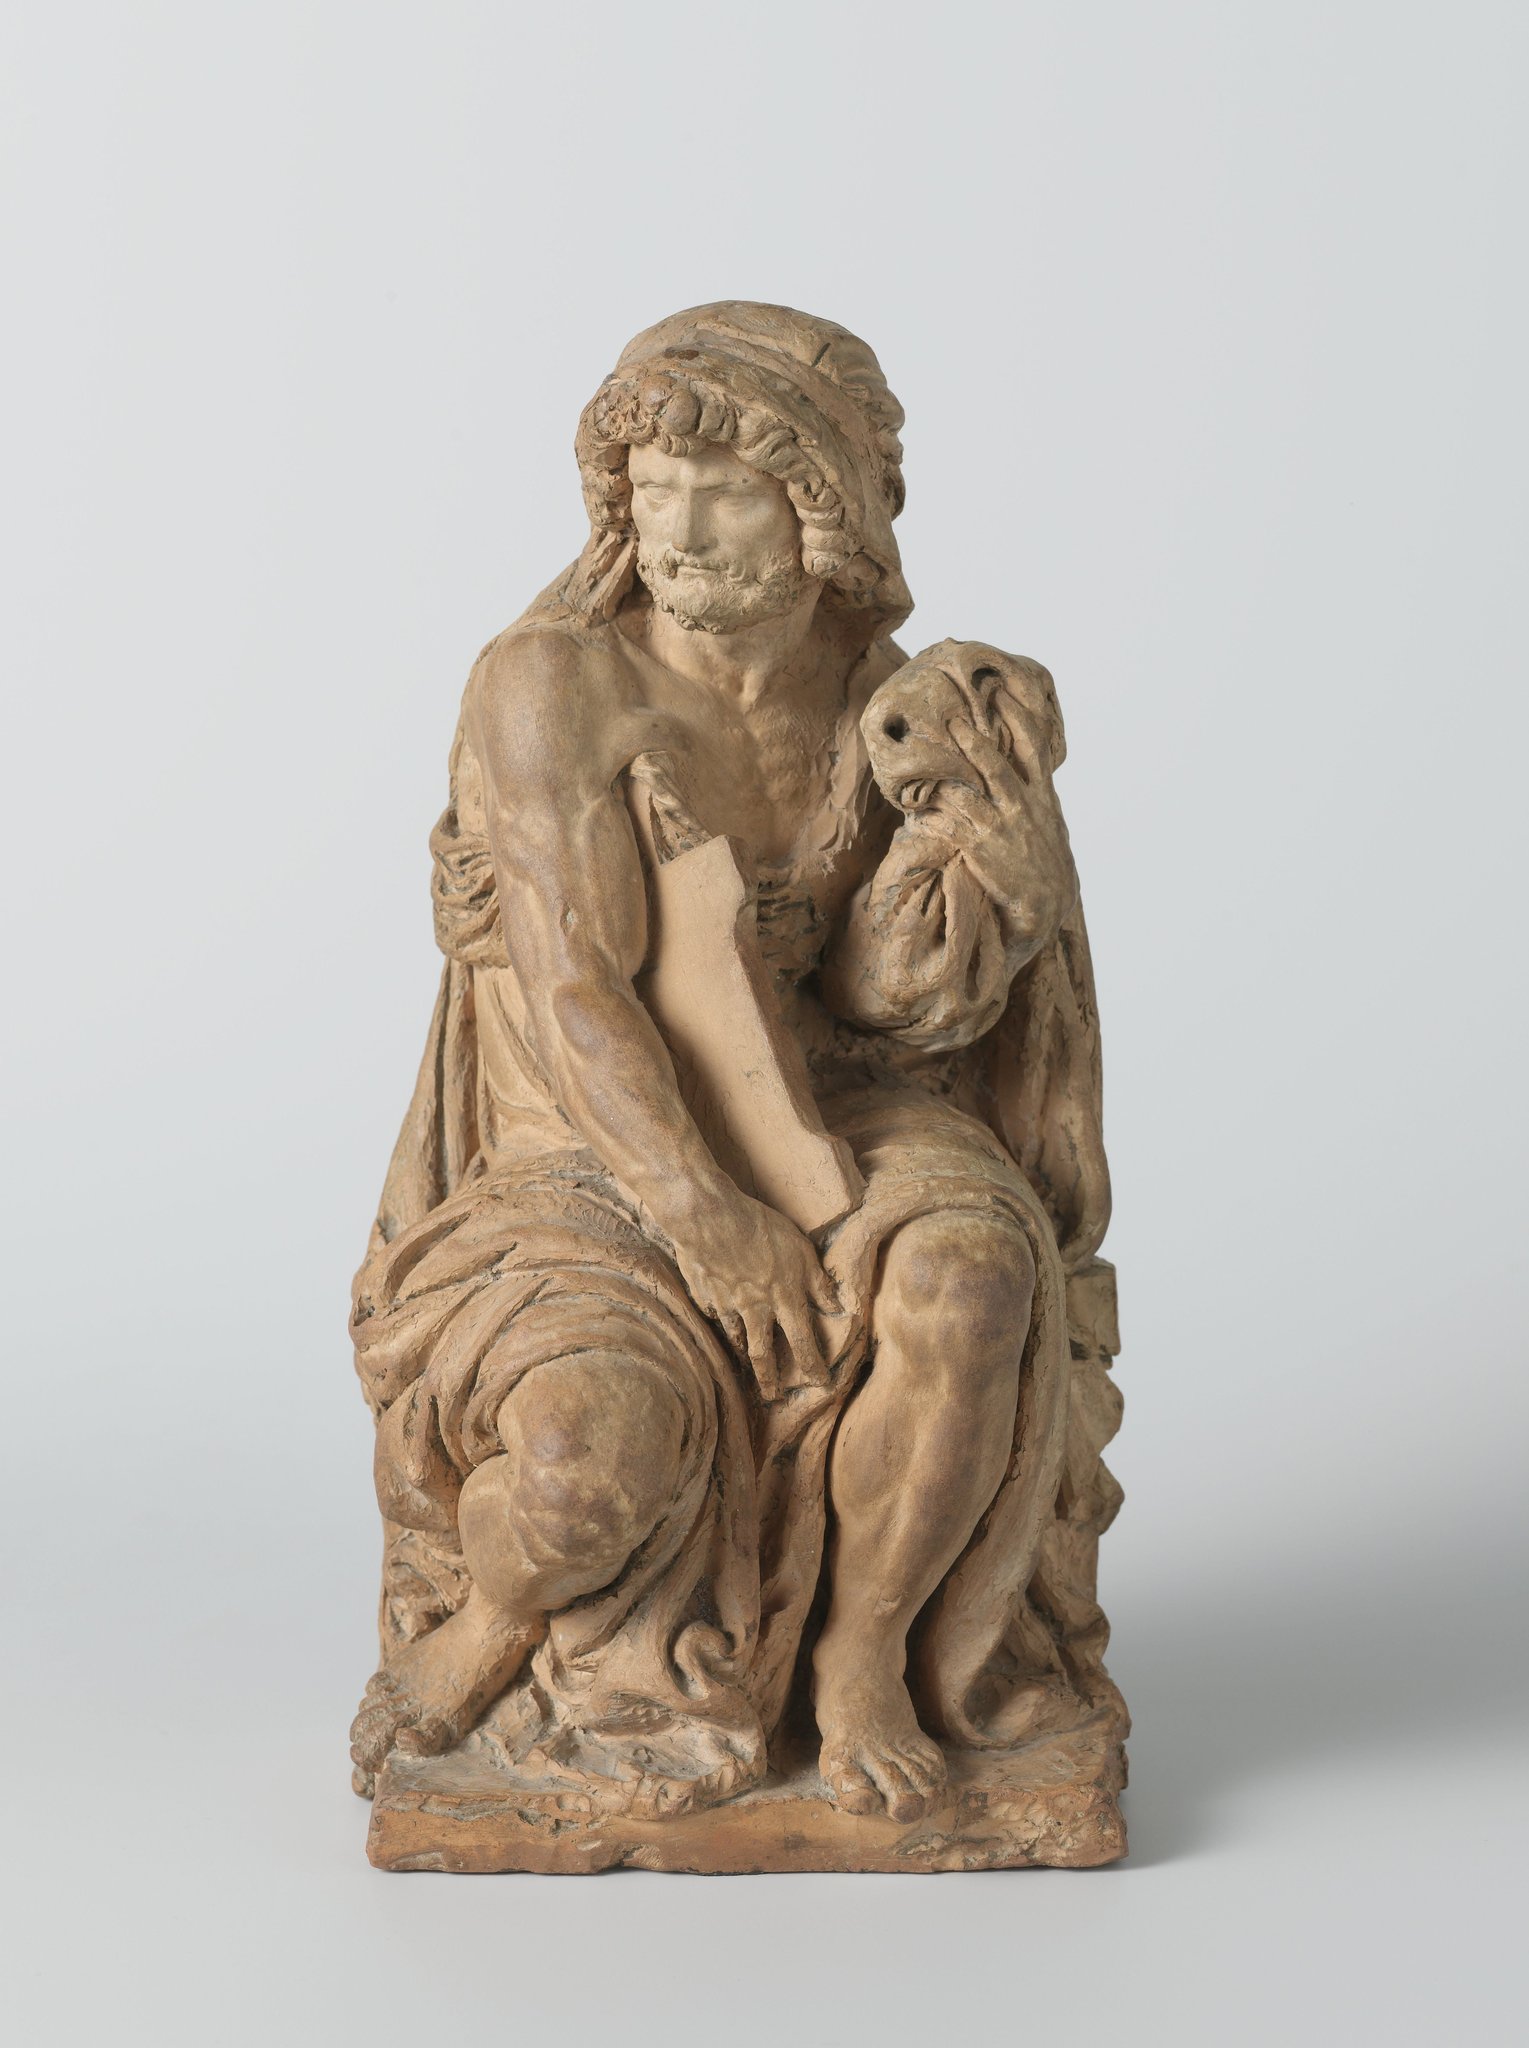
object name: modello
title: The Prophet Balaam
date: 1575-1577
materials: terracotta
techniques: modeling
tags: the story of balaam (numbers 22-24)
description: This sculpted modello or bozzetto is a design for a statue of the prophet Balaam intended for the basilica of the pilgrimage site of Loreto in Central Italy. The church was built around the Santa Casa, the house where, according to legend, the Virgin was born. The statuette stands out for its virtuoso modelling, as in the figure’s right arm and hand. It was long thought to be by Michelangelo.